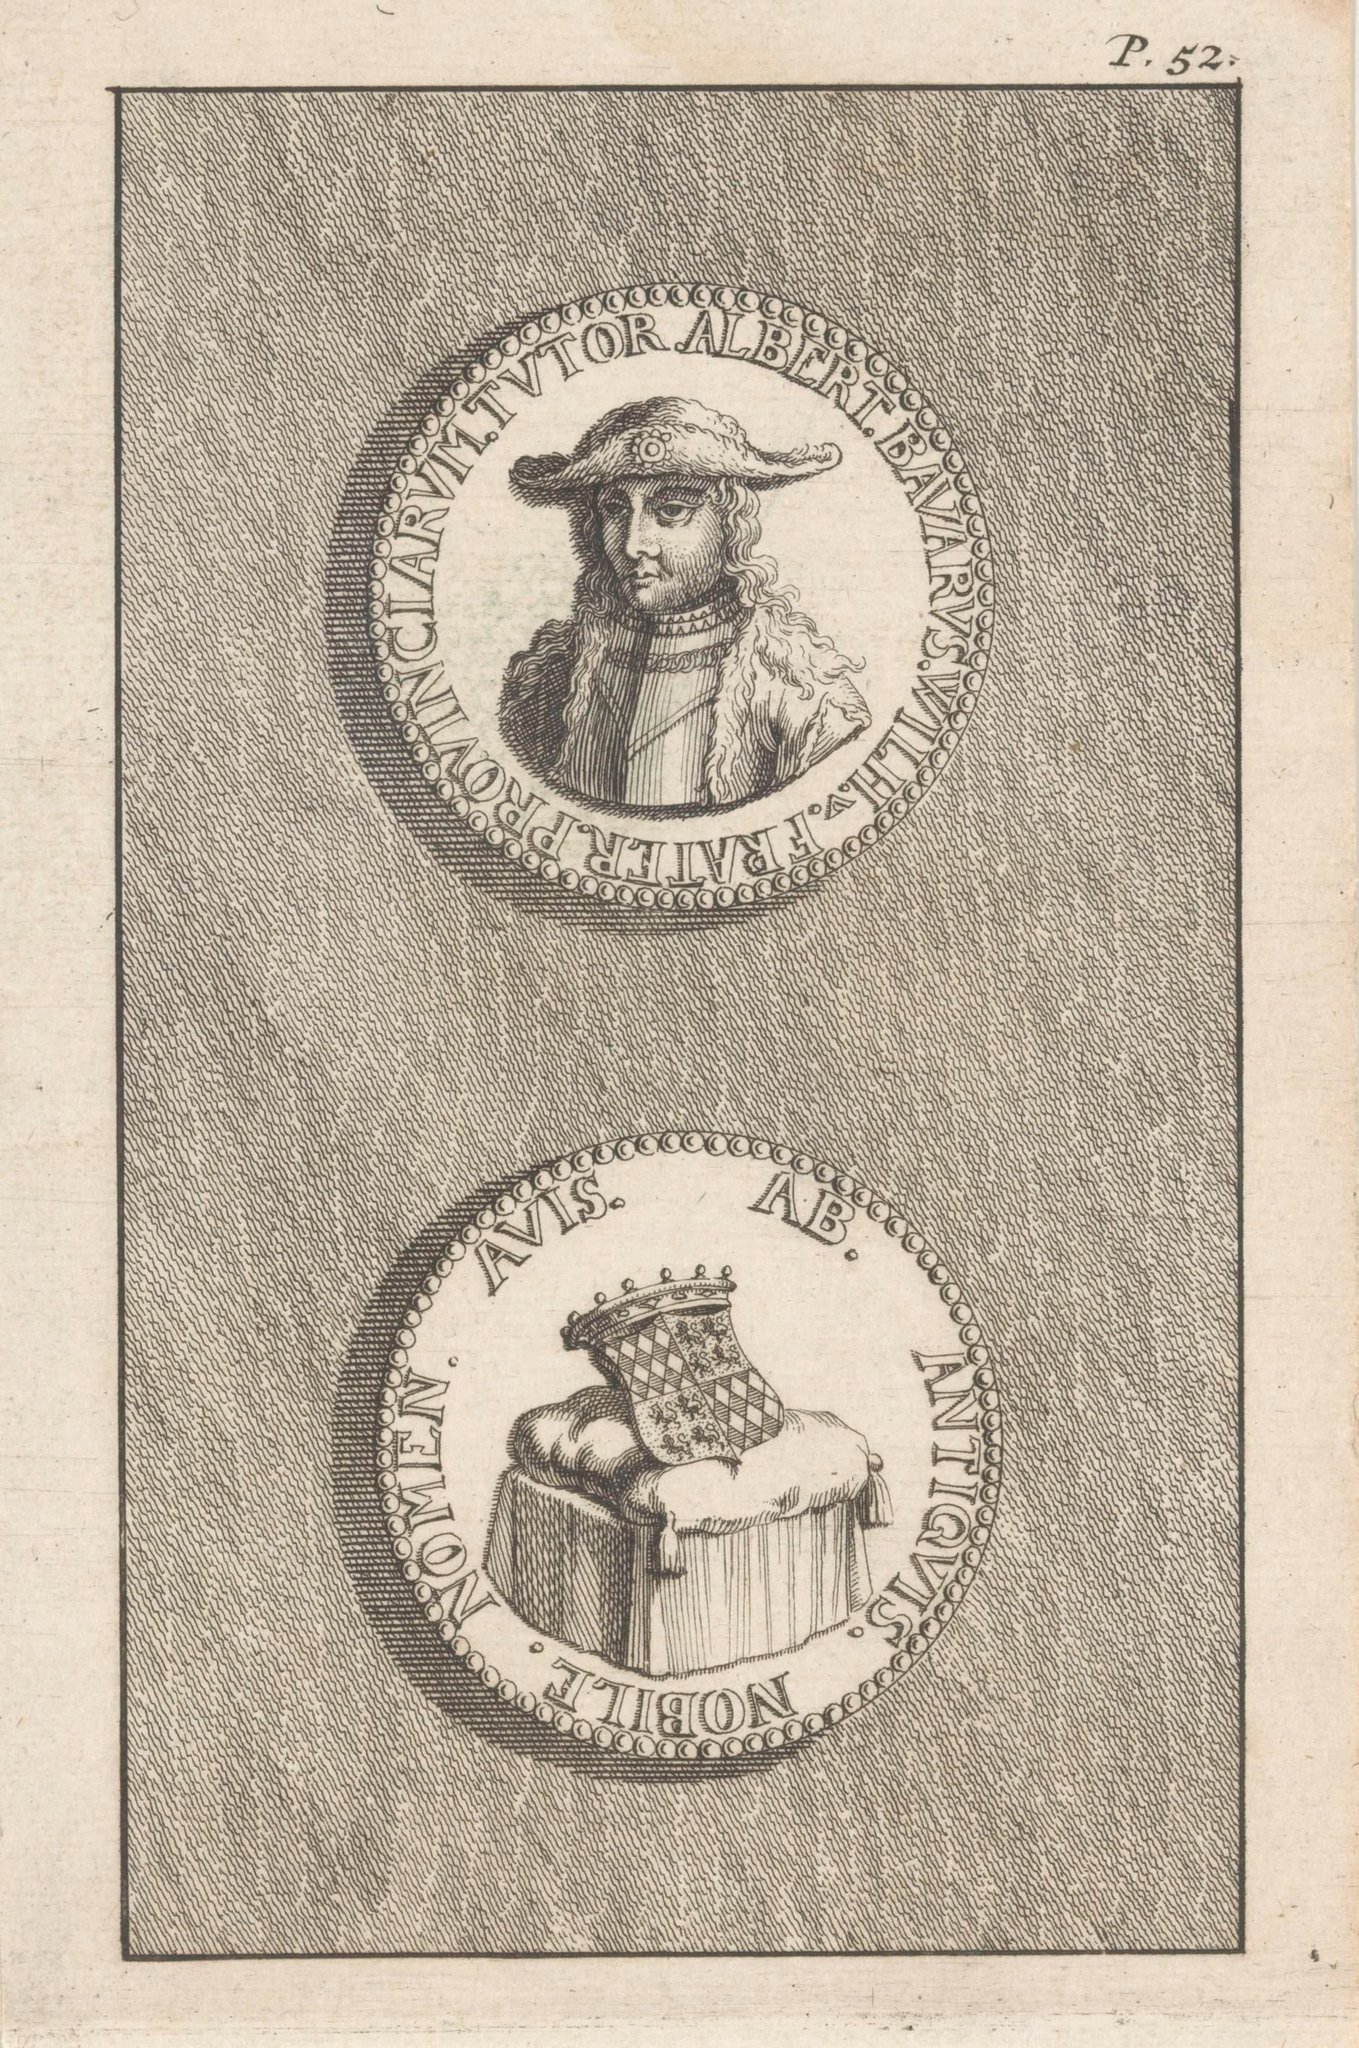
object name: print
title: Penning met portret van Albrecht van Beieren, graaf van Holland, Henegouwen en Zeeland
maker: Anonymous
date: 1600-1699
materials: paper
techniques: engraving, etching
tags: the hague, duke of bavaria albert i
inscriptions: collector's mark: Lugt 964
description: Boven: Portret van Albrecht van Beieren in een cirkelvormige omlijsting met randschrift. Onder: Zijn wapen met een kroon op een kussen in een cirkelvormige omlijsting met randschrift. Rechtsboven: P. 52.